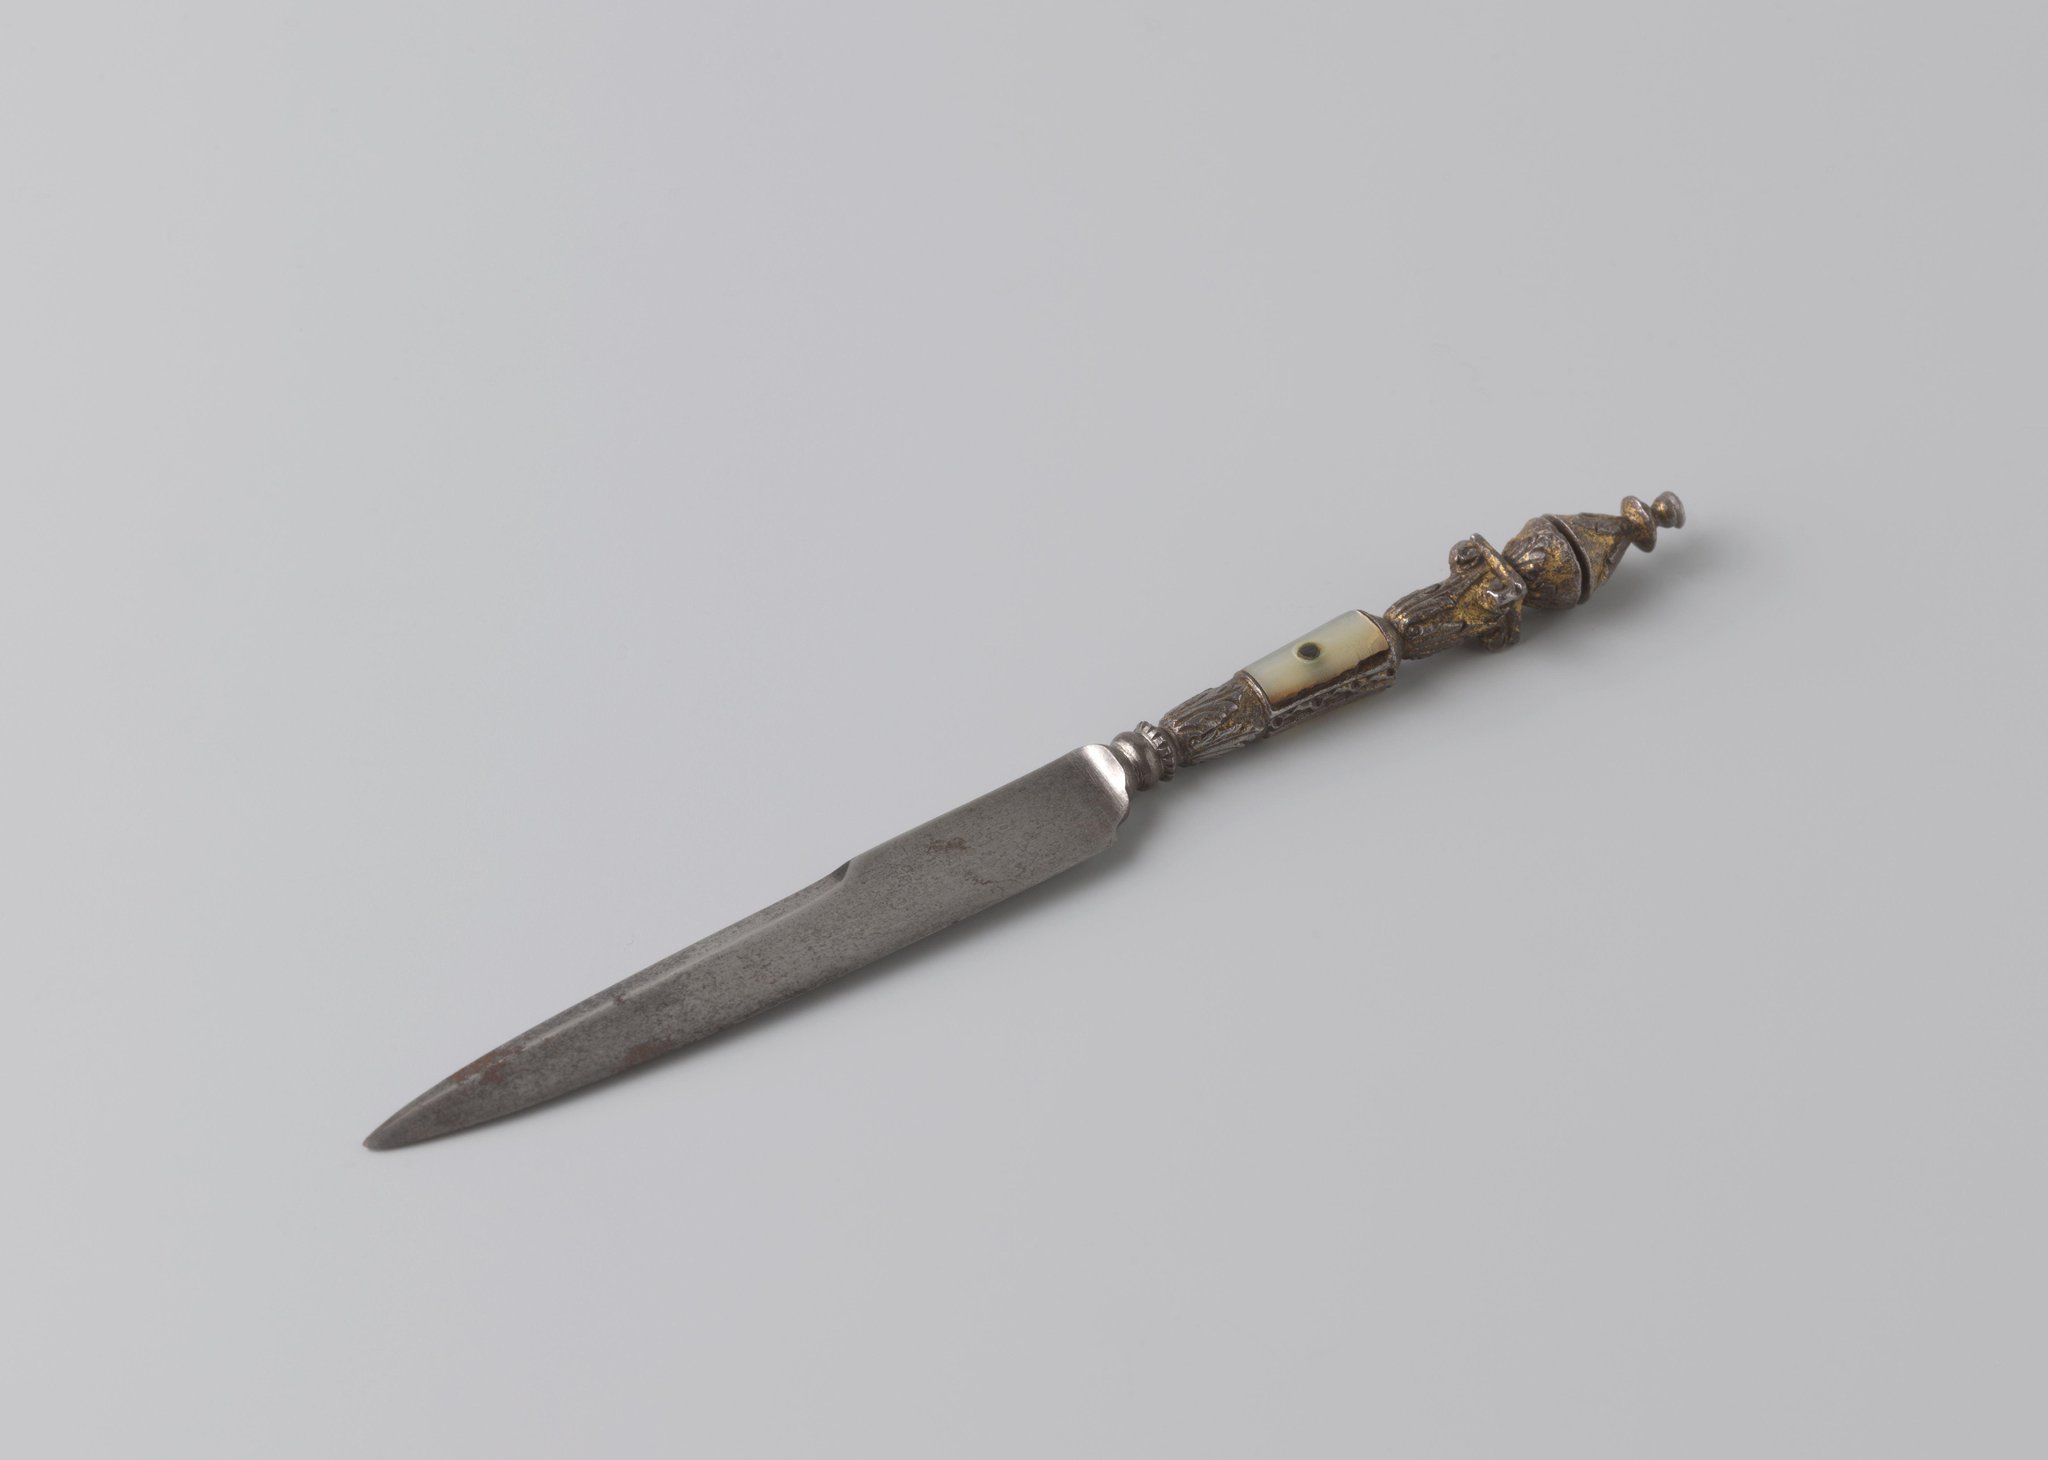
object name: knife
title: Mesje met heft ingelegd met parelmoer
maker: Anonymous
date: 1500-1700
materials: iron, mother of pearl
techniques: metalworking, gilding, inlay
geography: western europe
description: Mes van ijzer. Het vergulde heft ingelegd met parelmoer, is versierd met palmbladeren en voluten.